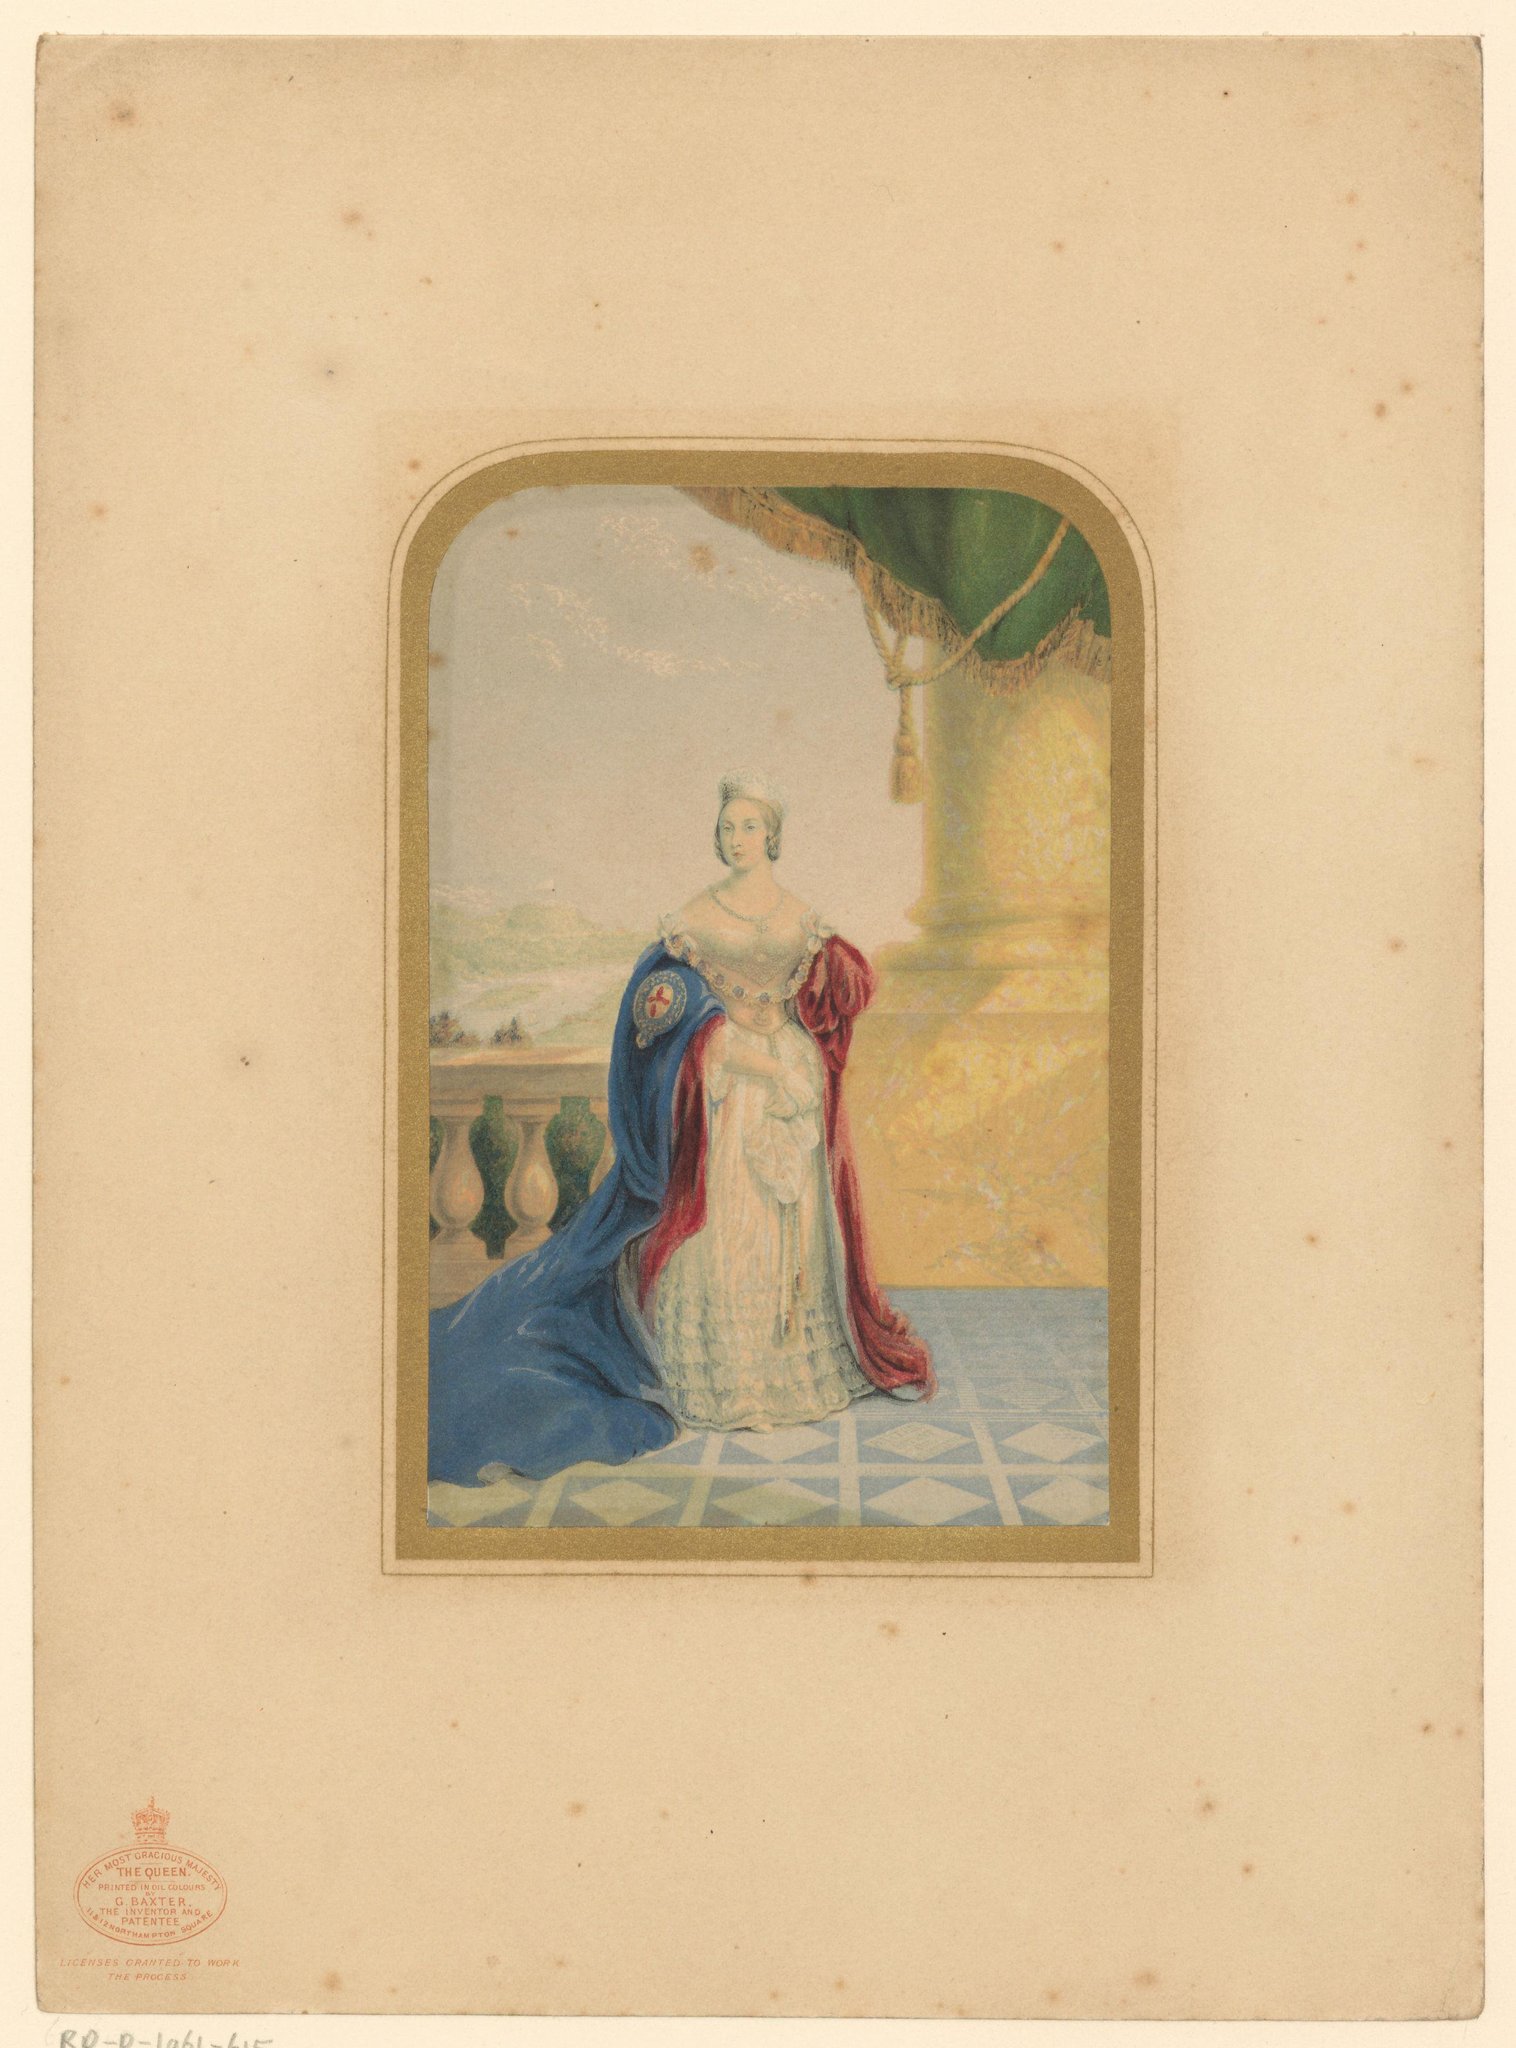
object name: print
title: Portret ten voeten uit van koningin Victoria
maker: george baxter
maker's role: print maker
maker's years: 1804-1867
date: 1848-1849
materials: paper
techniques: aquatint, printmaking, etching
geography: london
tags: victoria (koningin van het verenigd koninkrijk en keizerin van india), historical persons, queen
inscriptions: stamp: ‘Her Most Gracious Majesty the Queen printed in oil colours by G. Baxter, the inventor and patentee (...) Licenses granted to work the process’, collector's mark: Lugt 2228